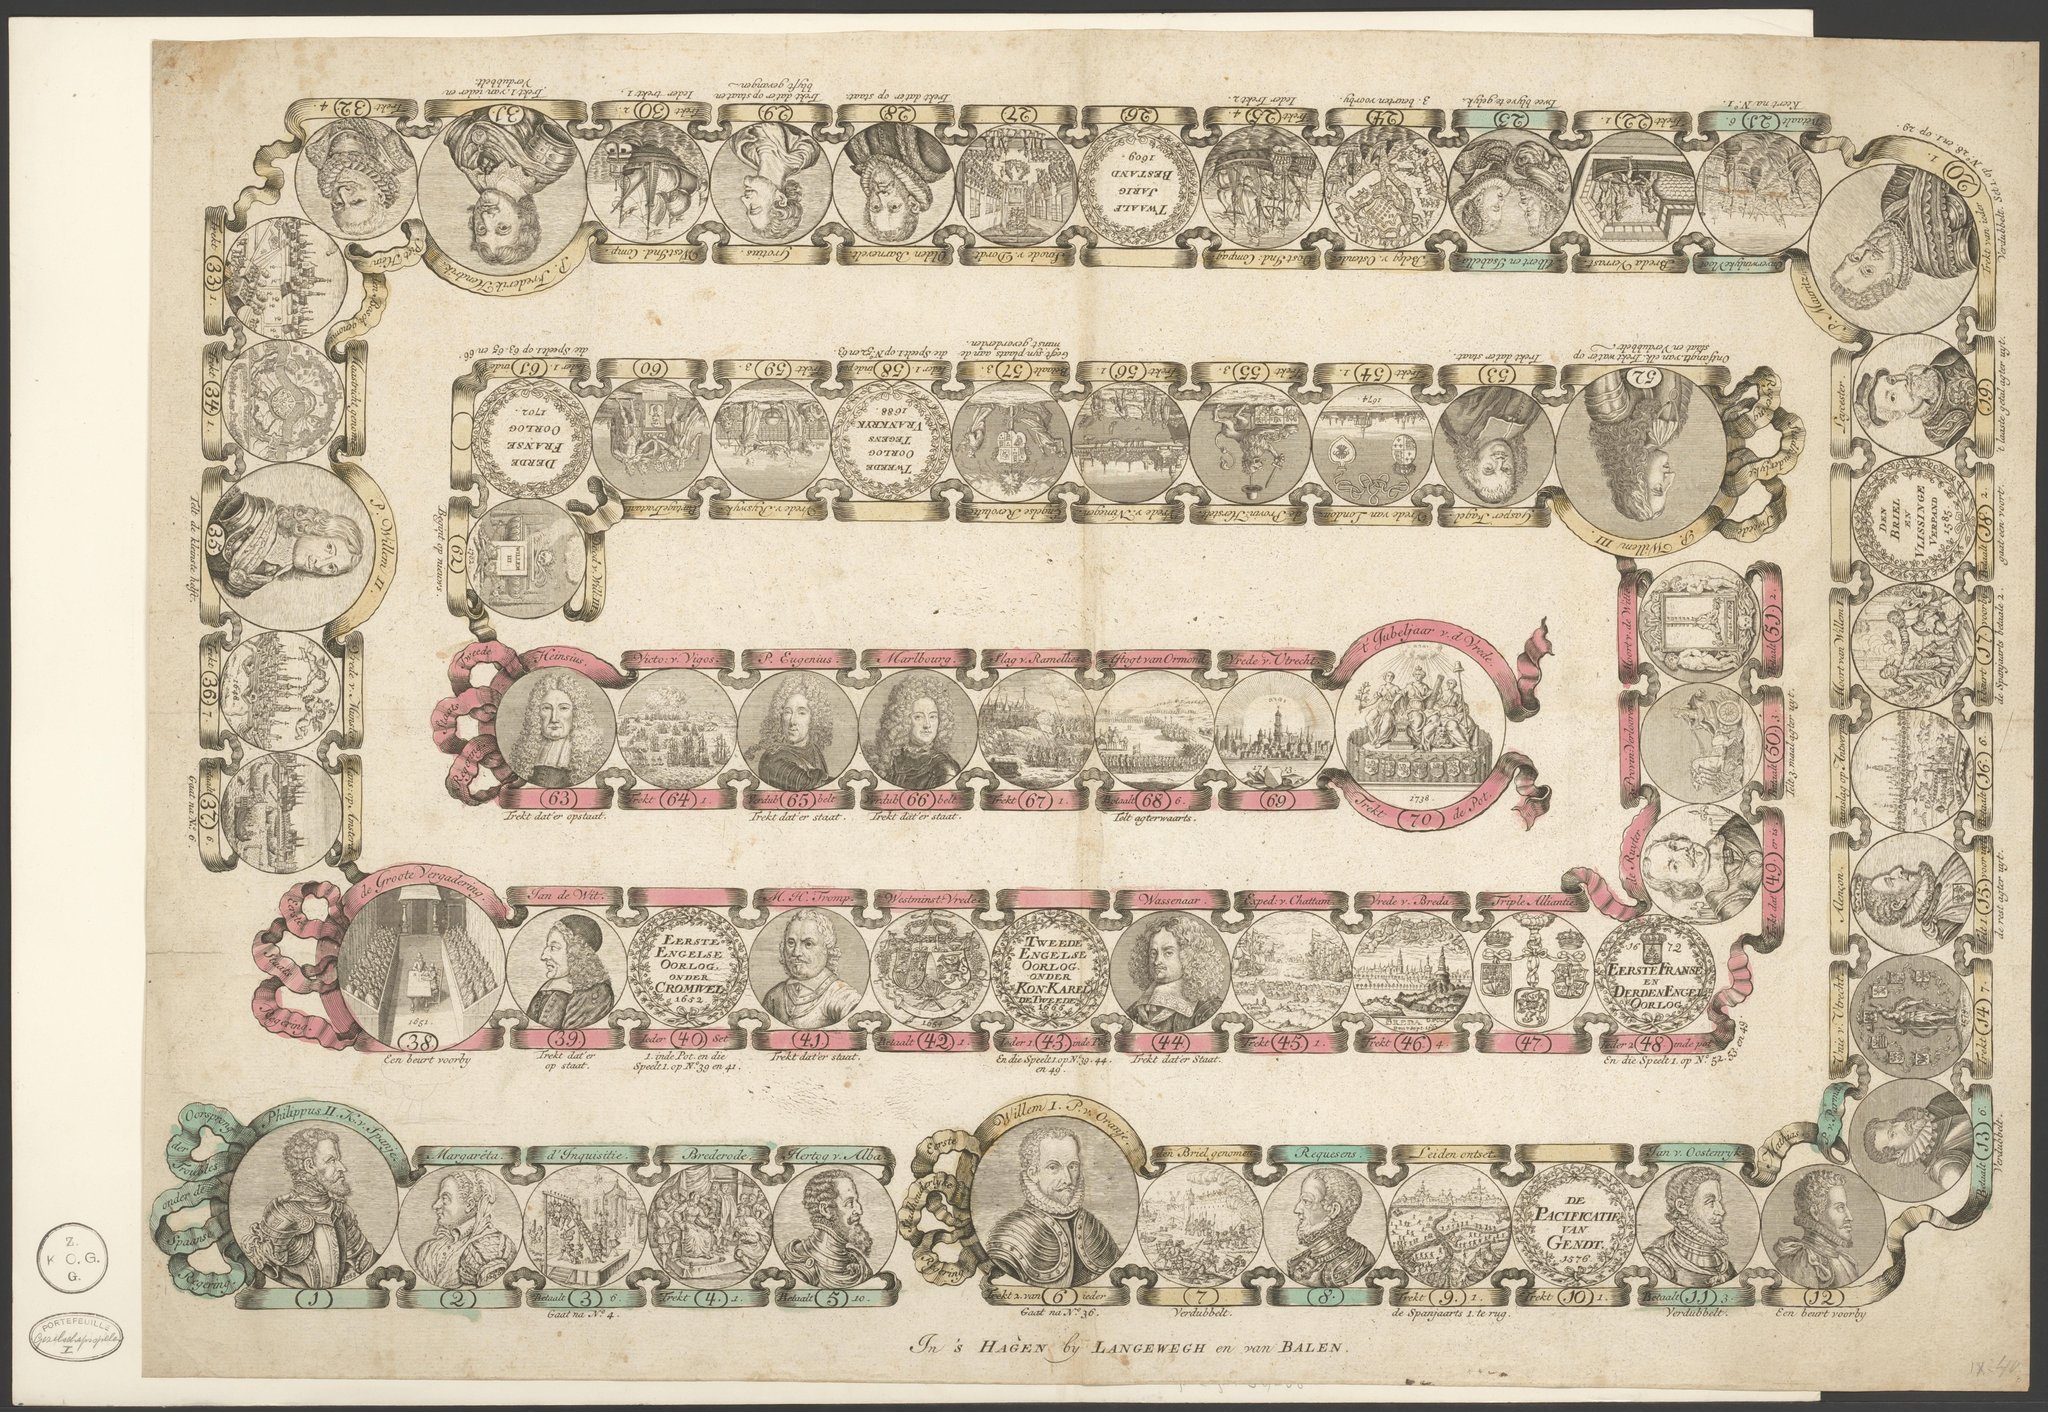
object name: print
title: Spel verbeeldende de historie van Holland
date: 1756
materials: paper, watercolor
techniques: engraving, etching, hand coloring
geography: the hague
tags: board-games of chance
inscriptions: collector's mark: Lugt 1641, collector's mark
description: Bordspel over de Nederlandse geschiedenis. Spel met 70 medaillons beginnend bij Filips II en eindigend bij het jaar 1738, het jubeljaar van de Vrede van Utrecht in 1713. Elk vakje verwijst naar een historische gebeurtenis of persoon, vermeld op een lint dat de medaillons met elkaar verbindt. Bij de prent behoort een afzonderlijk boekje met de spelregels. Onderwerpsrubrieken binnen de Atlas Zeden en Gewoonten: Spel en Vermaak; gezelschapsspel, ganzenbord en dergelijke.